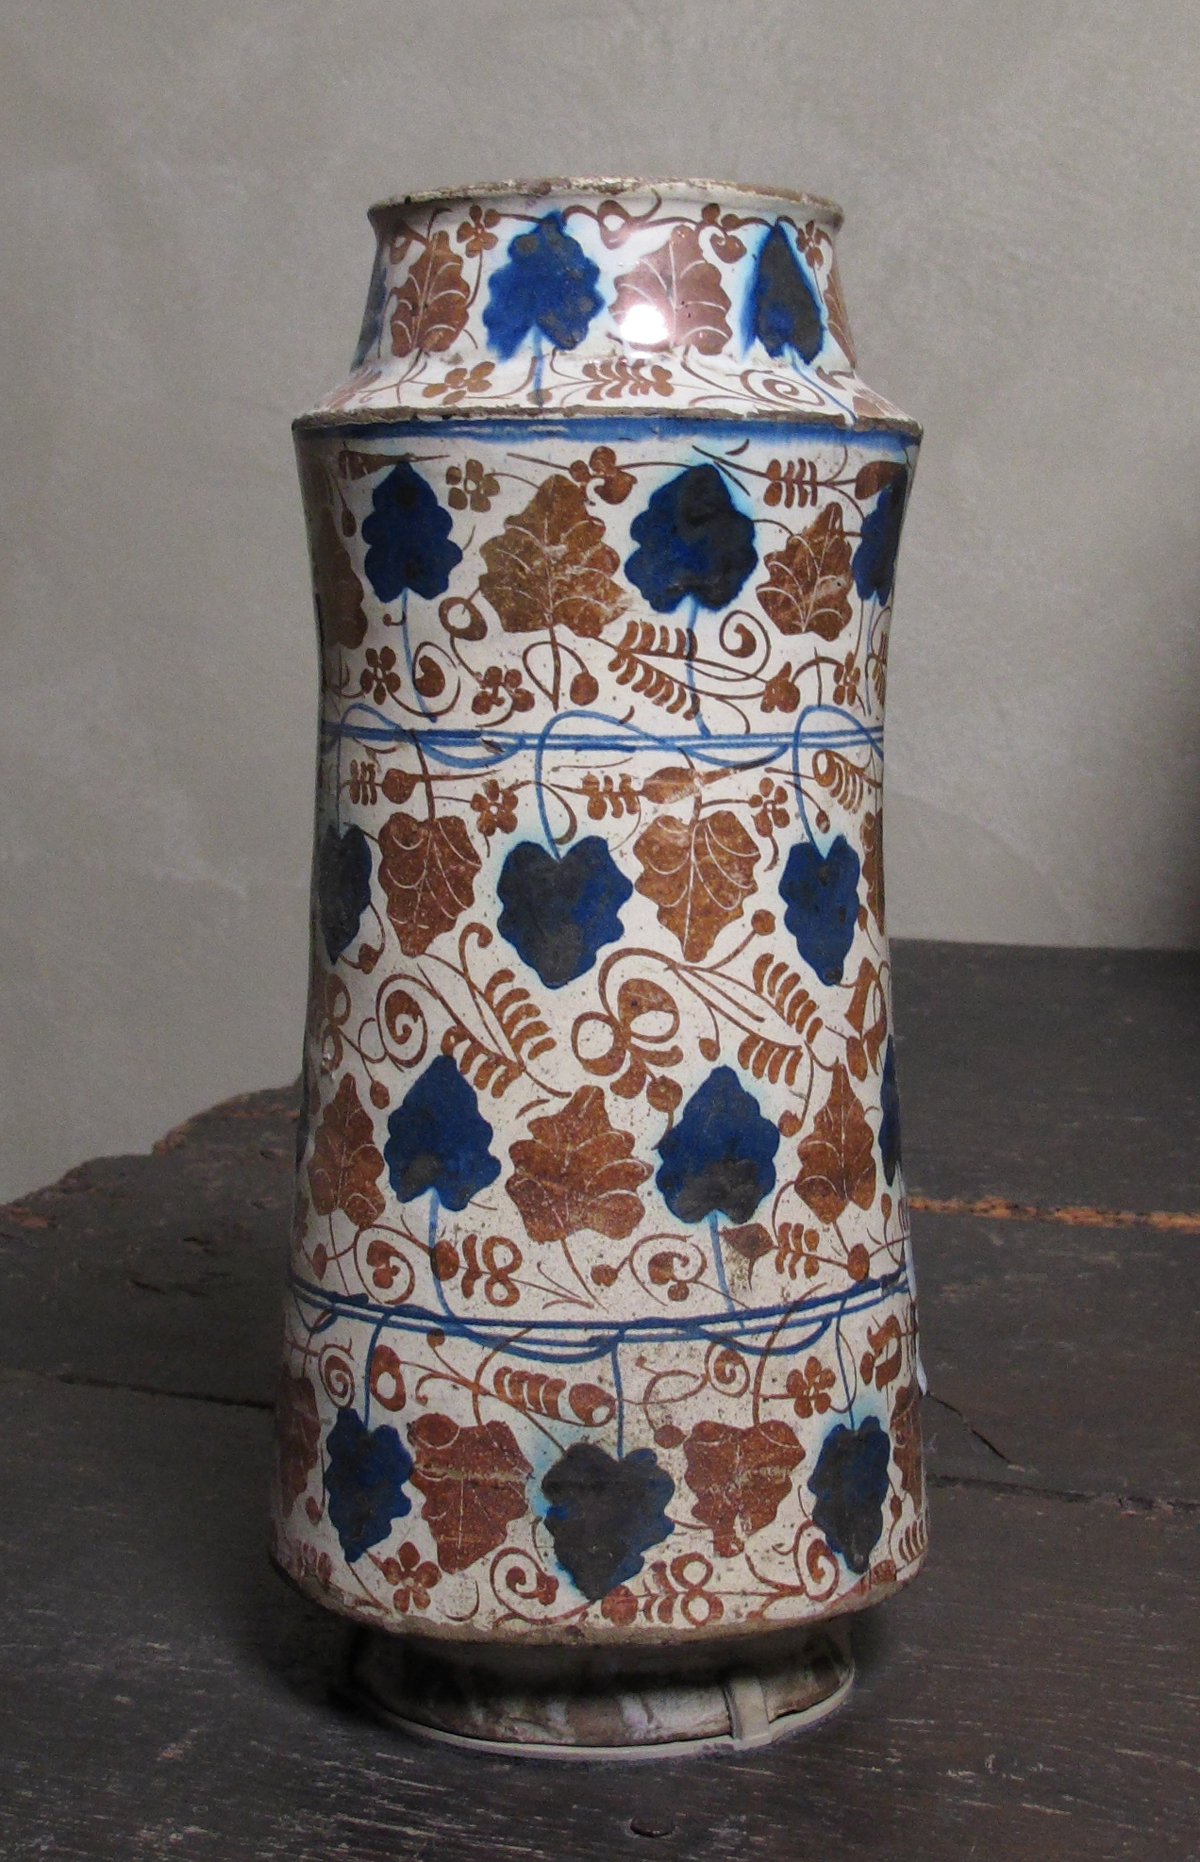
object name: pharmacy jar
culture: spanish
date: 1435-1465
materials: earthenware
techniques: glazing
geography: spain